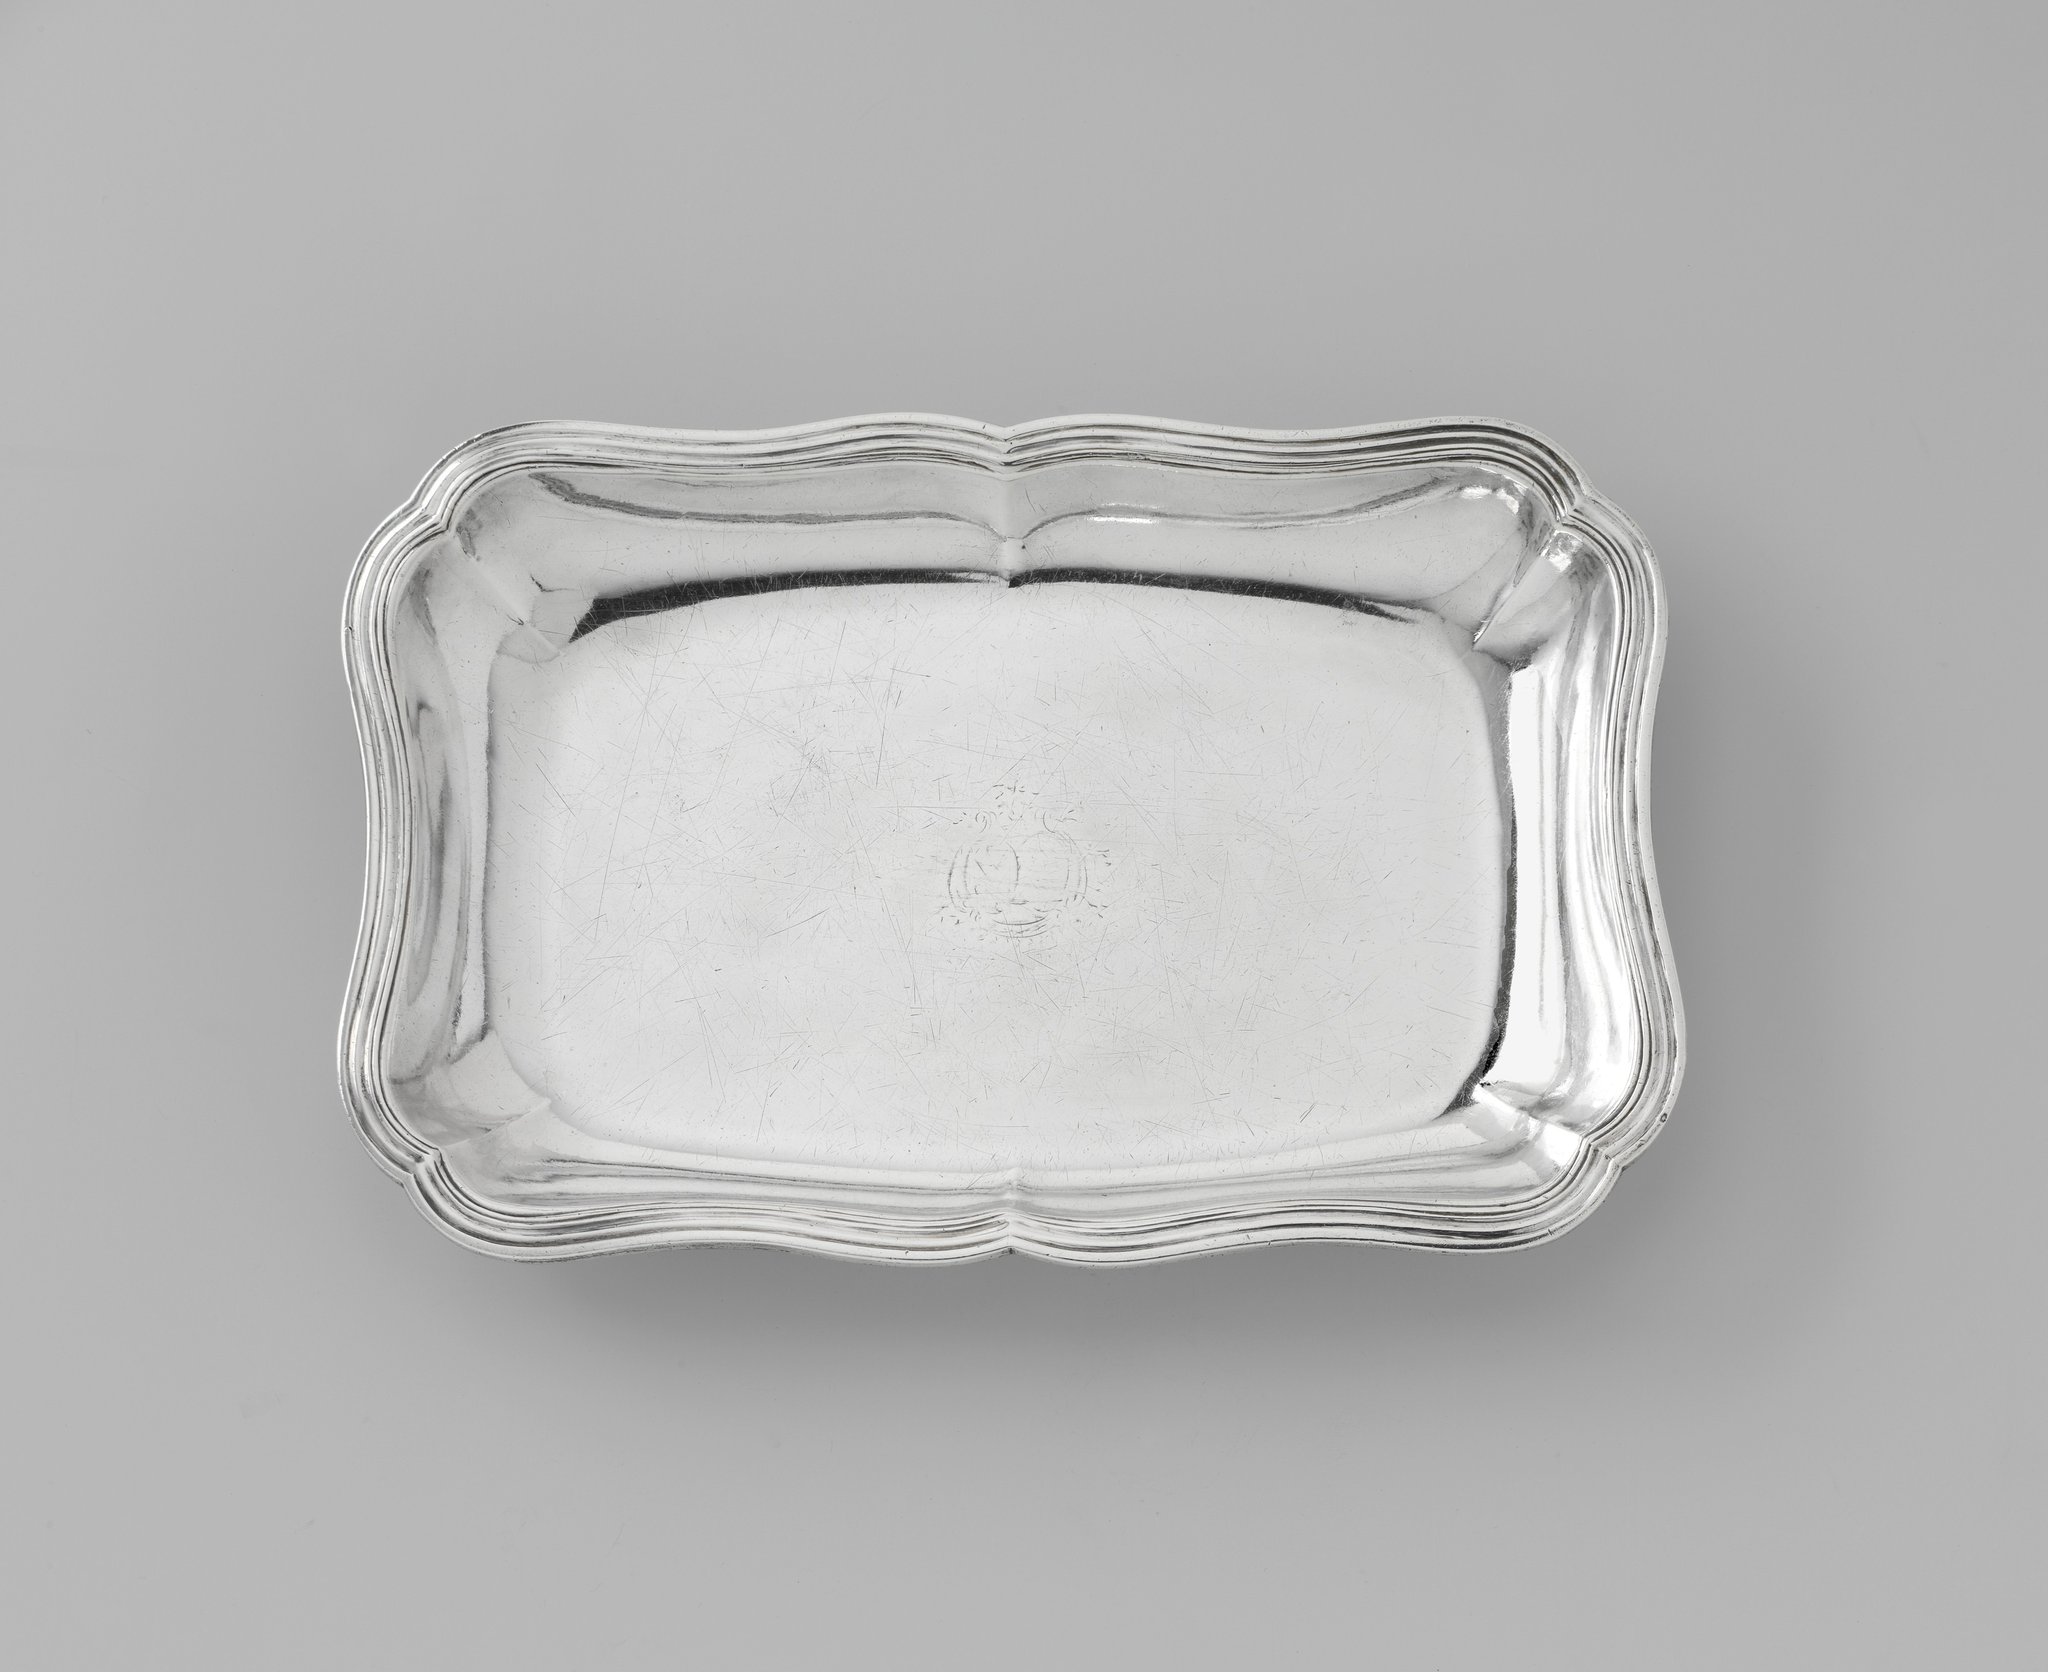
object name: dish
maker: gabrielle bidard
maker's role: maker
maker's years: 1723-1772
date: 1756-1758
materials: silver